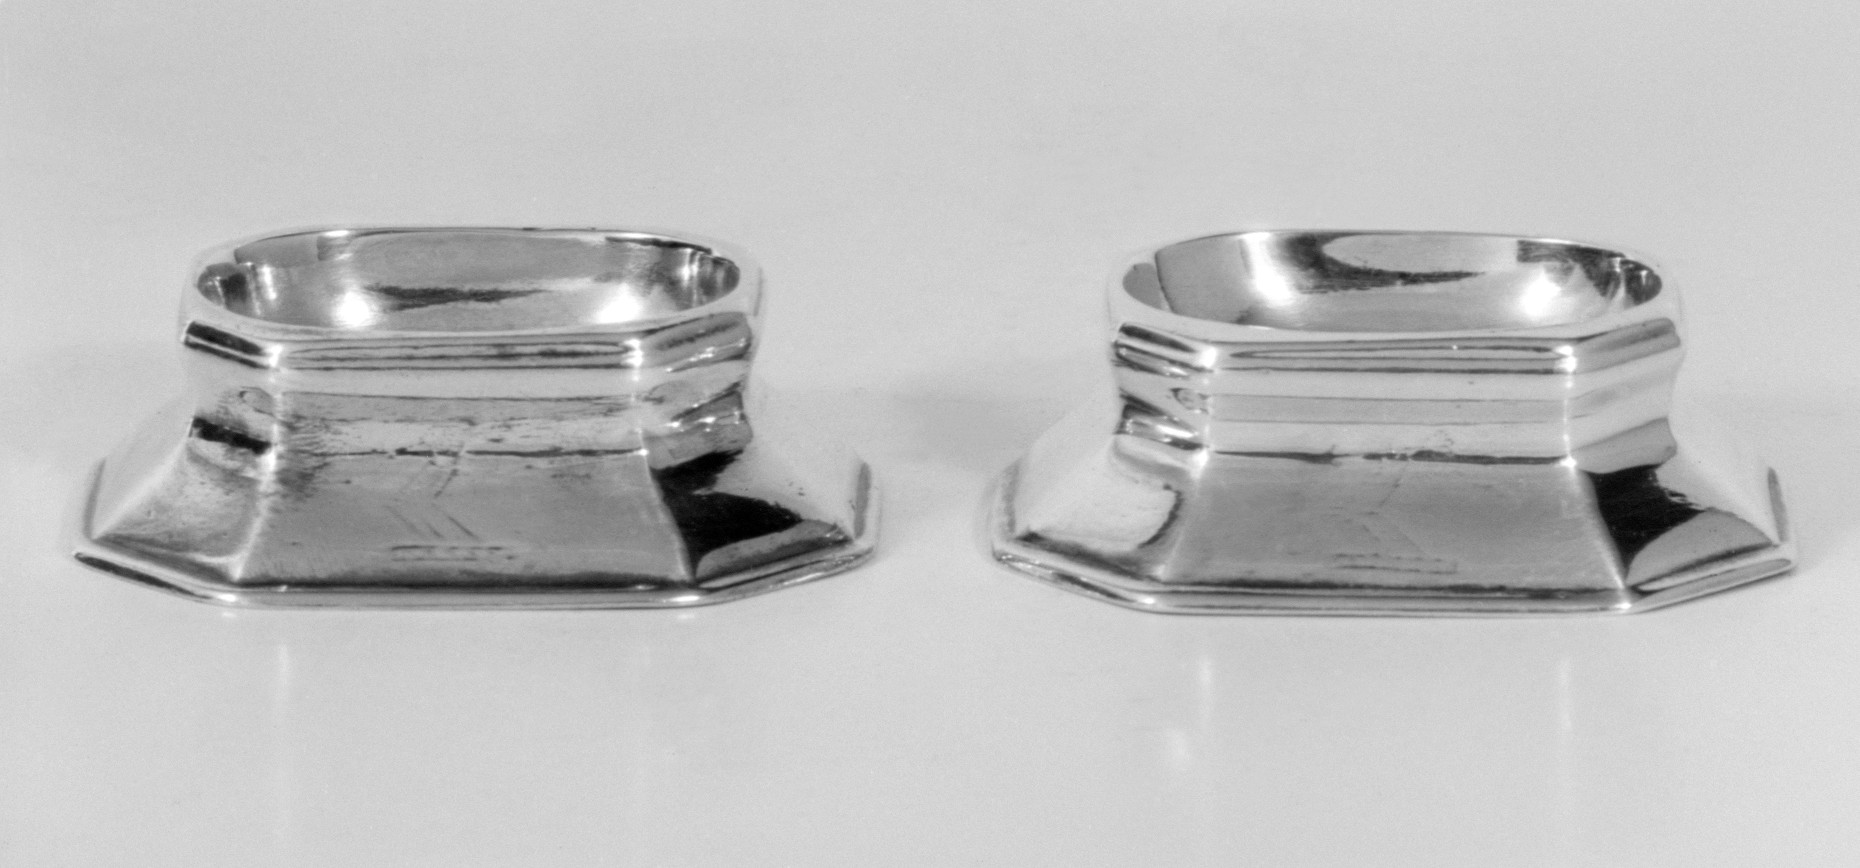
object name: saltcellar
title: Pair of saltcellars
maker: thomas folkingham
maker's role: maker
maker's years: 1703-1729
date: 1714-1715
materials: silver